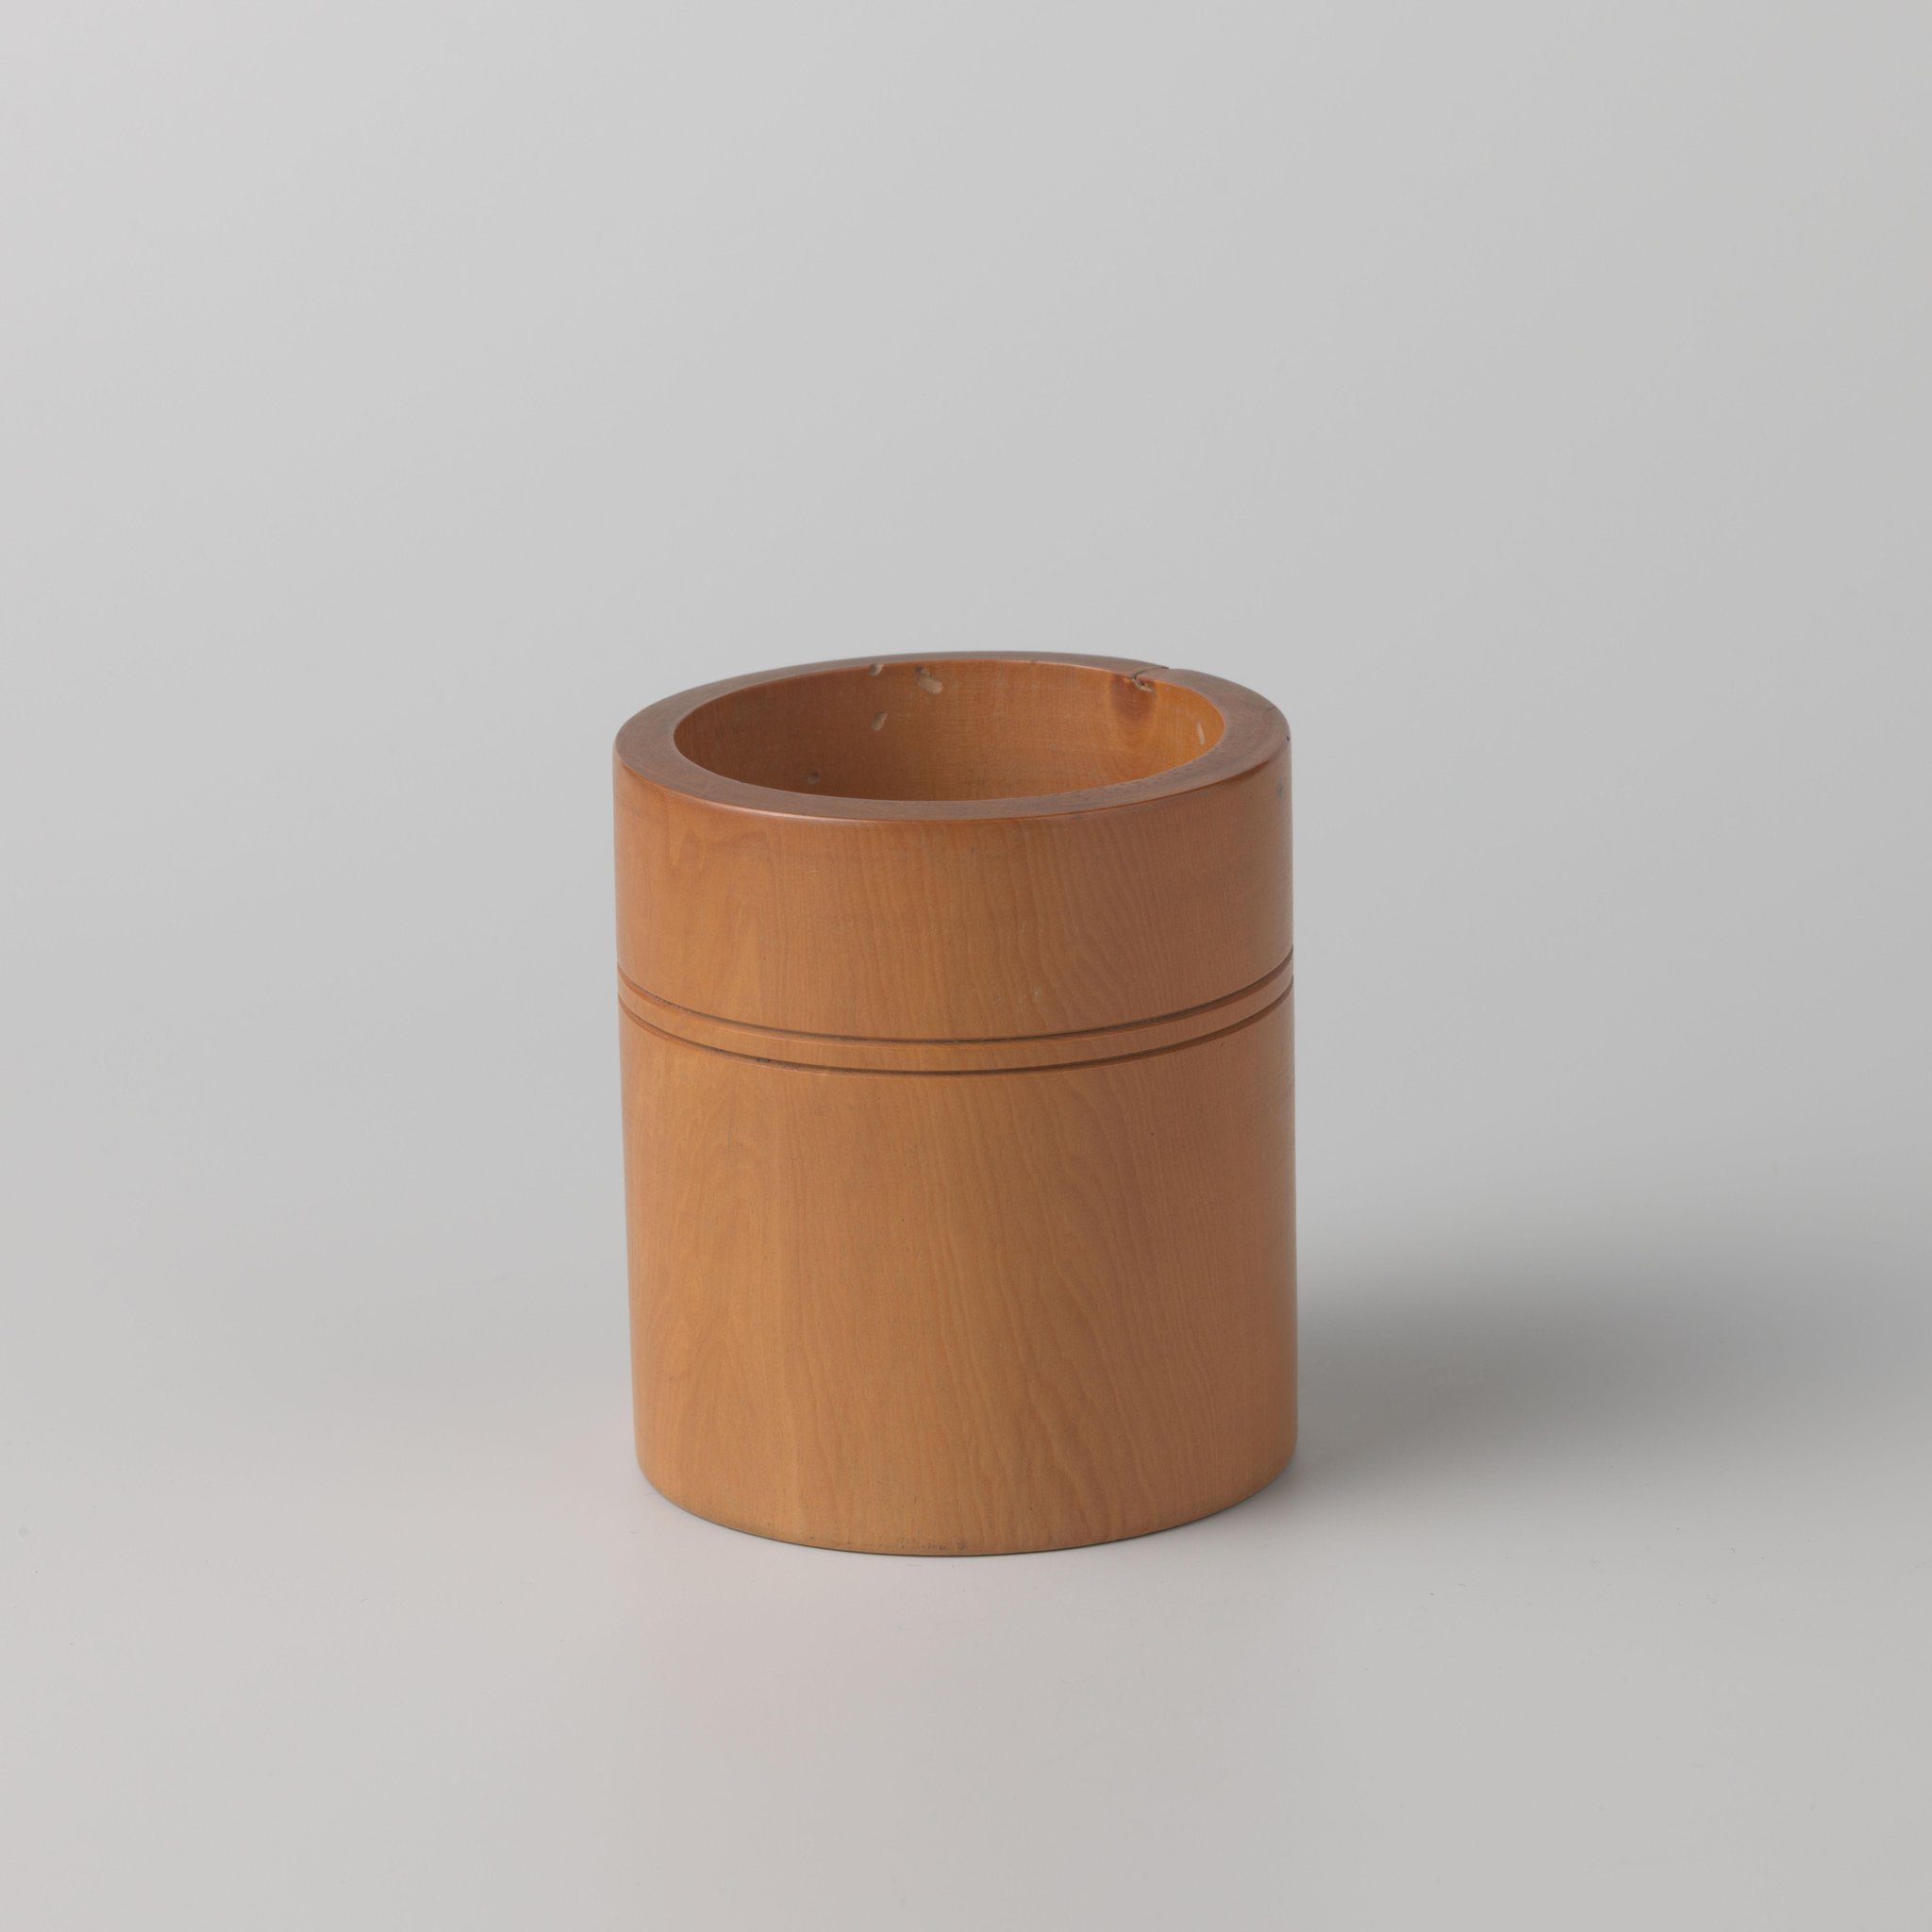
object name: inhoudsmaat droge waren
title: Cilindrische inhoudsmaat van 2 (?) dl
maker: Anonymous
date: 1825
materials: wood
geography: netherlands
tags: netherlands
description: Gedraaide houten inhoudsmaat. Aan de buitenzijde v.z.v. 2 cirkelvormige groeven (2 wijst op 2 deciliter); verder geen opschriften, stempels of inhoudsaanduiding.